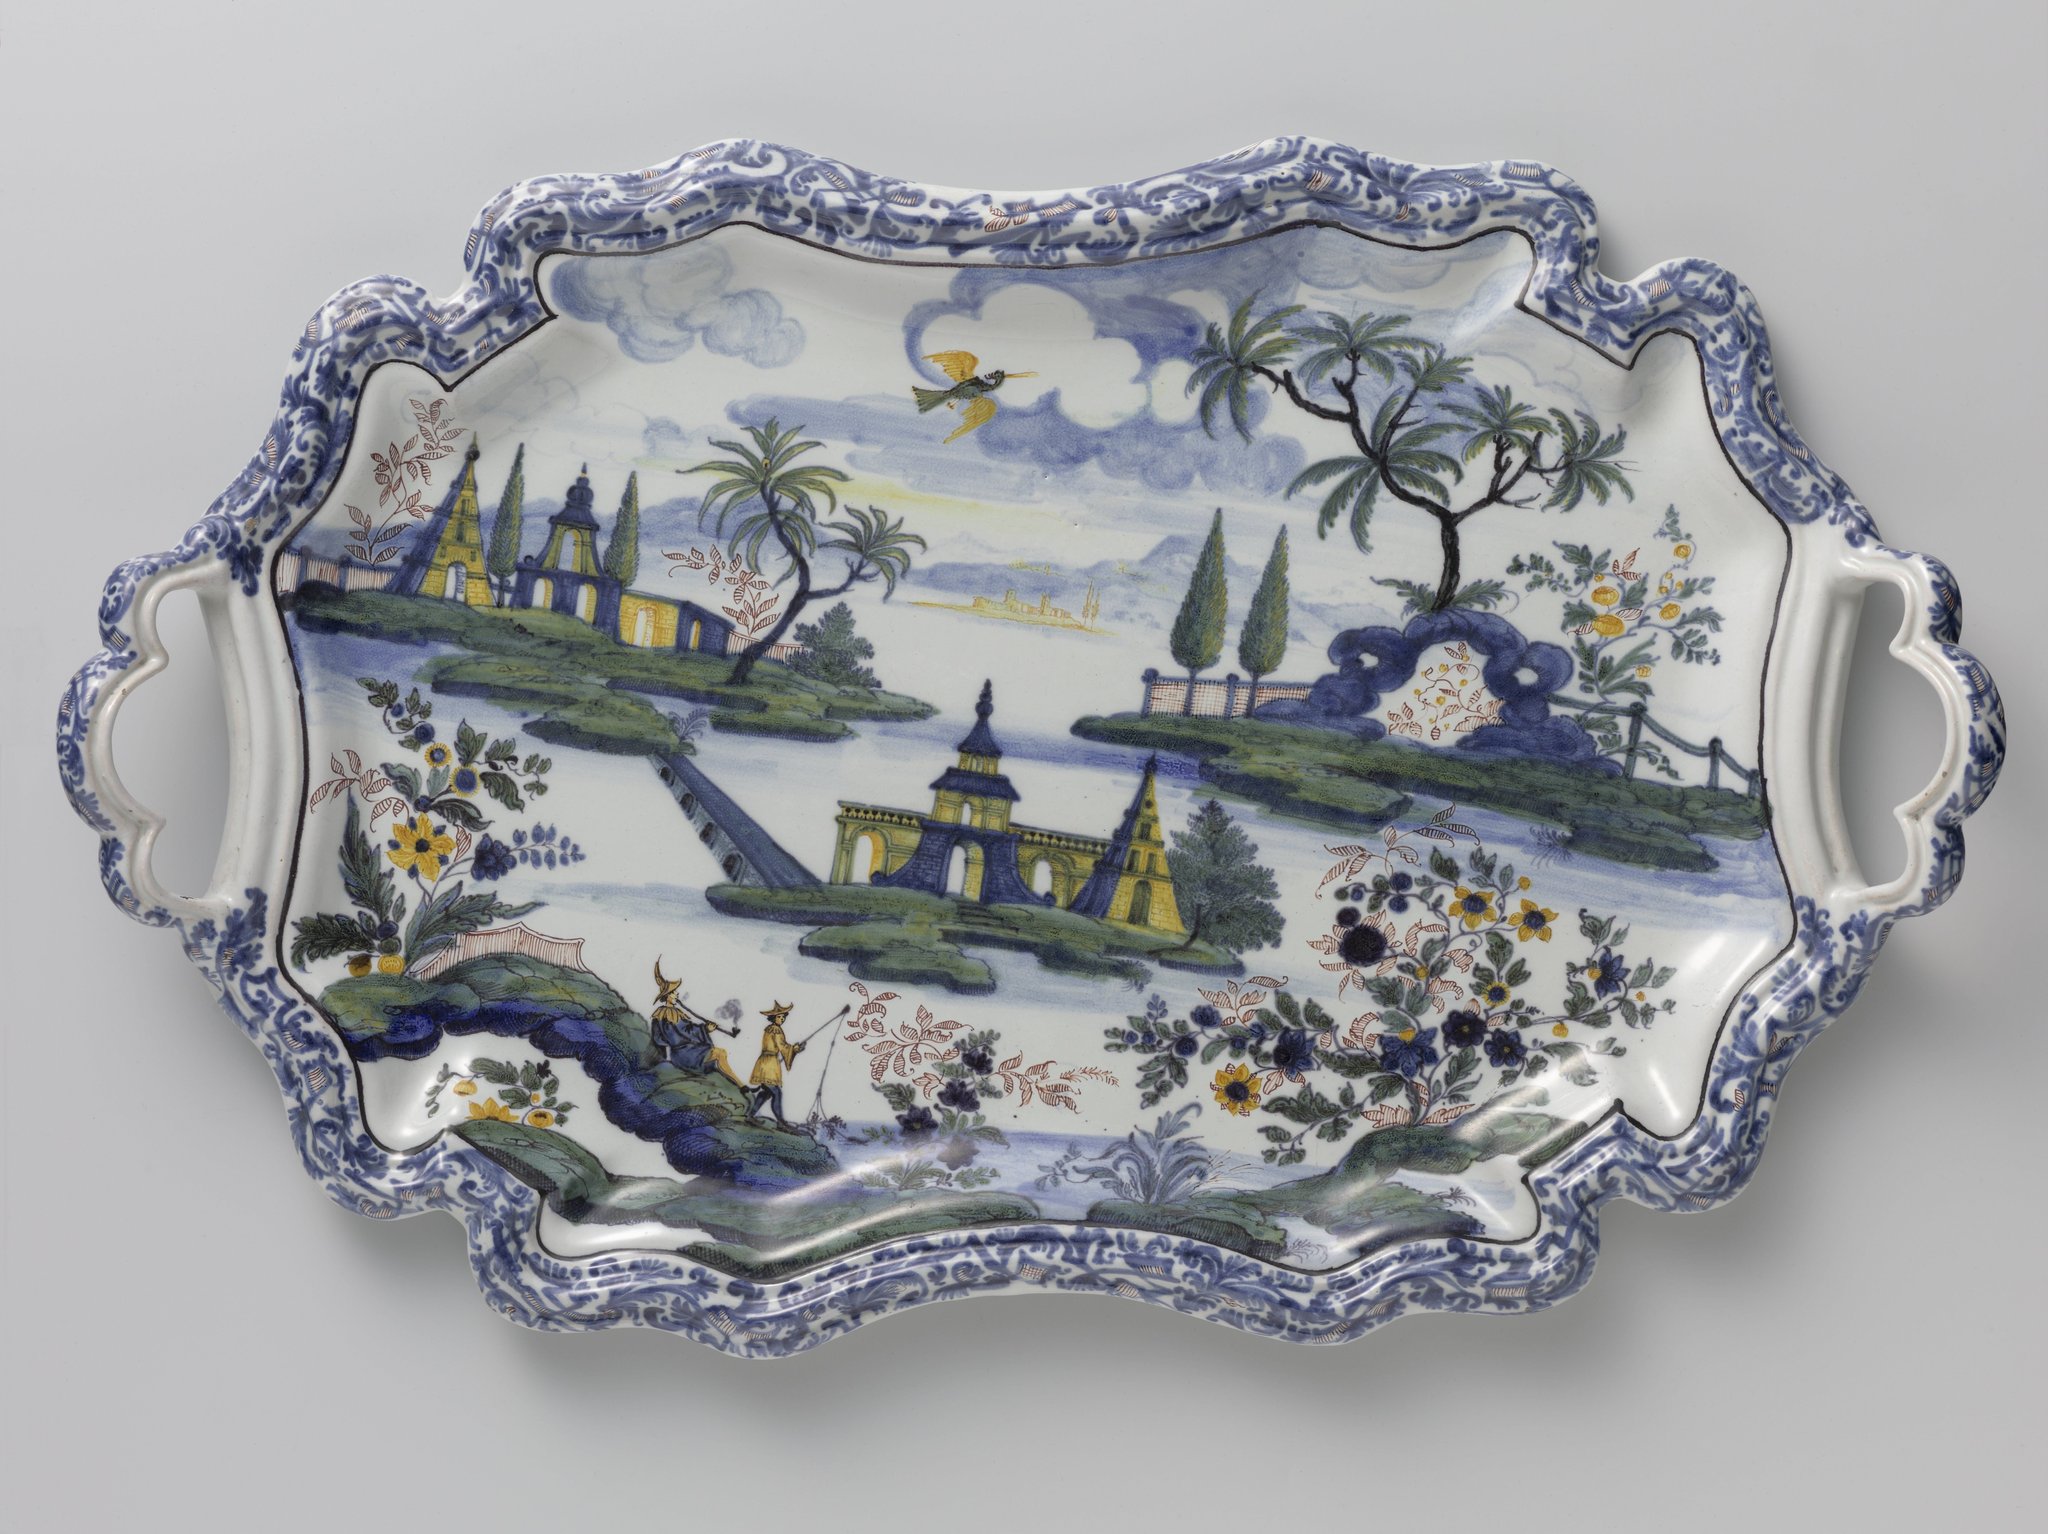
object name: blad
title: Dienblad, beschilderd met chinoiserieën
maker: pasquale antonibon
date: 1760-1775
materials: faience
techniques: painted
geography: nove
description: Tray. Faience with grand feu decoration. Nove di Bassano (Italy), c. 1760 - 1775, factory of Pasquale Antonibon.